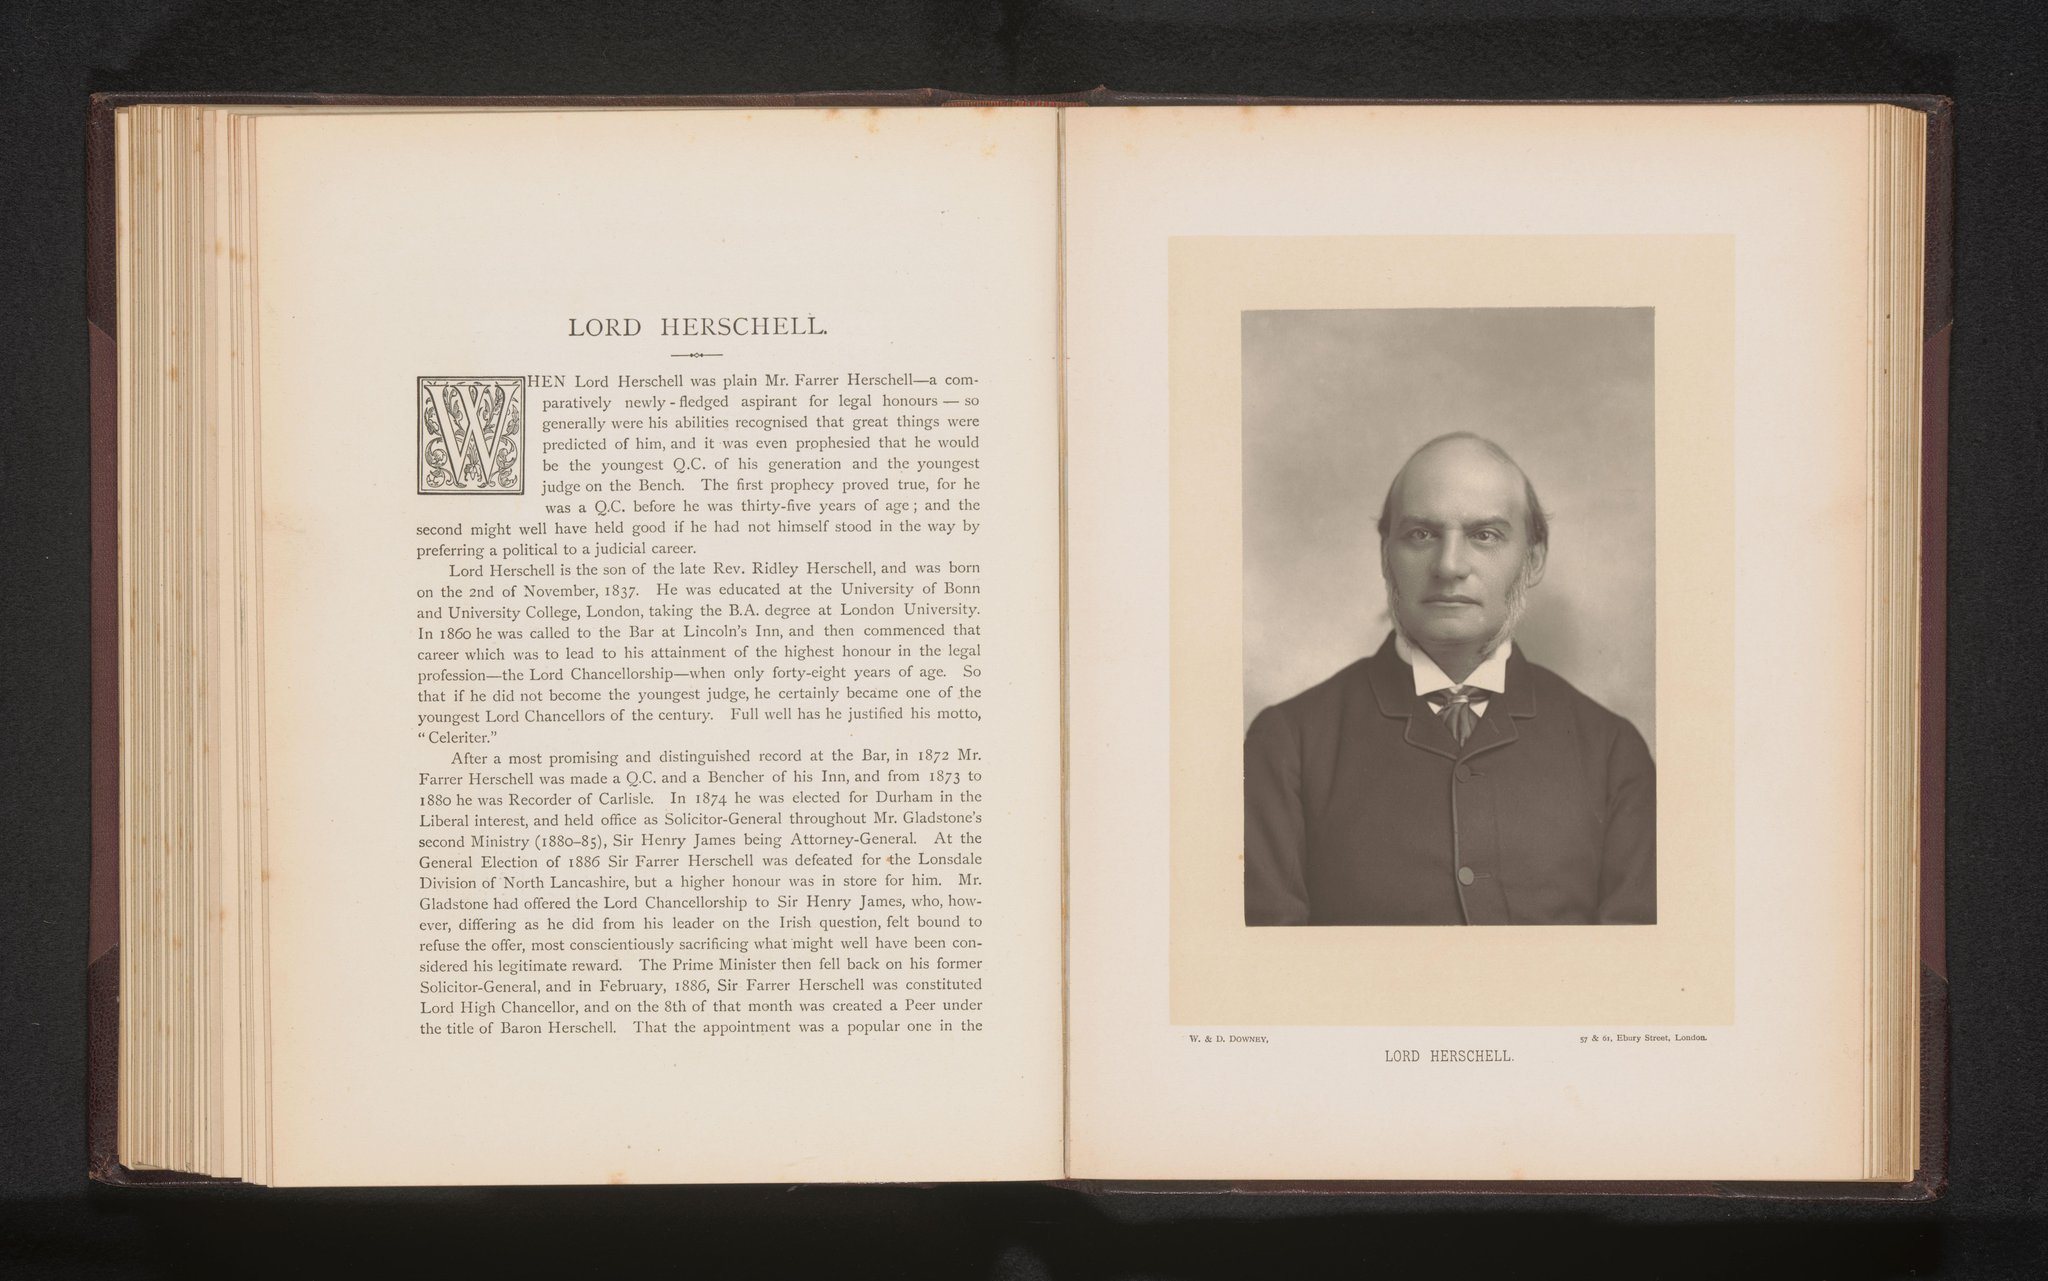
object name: photograph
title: Portret van Farrer Herschell, eerste baron Herschell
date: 1885-1890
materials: paper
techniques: carbon print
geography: london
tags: politician, historical persons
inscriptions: address: ‘57 & 61, Ebury Street, London.’